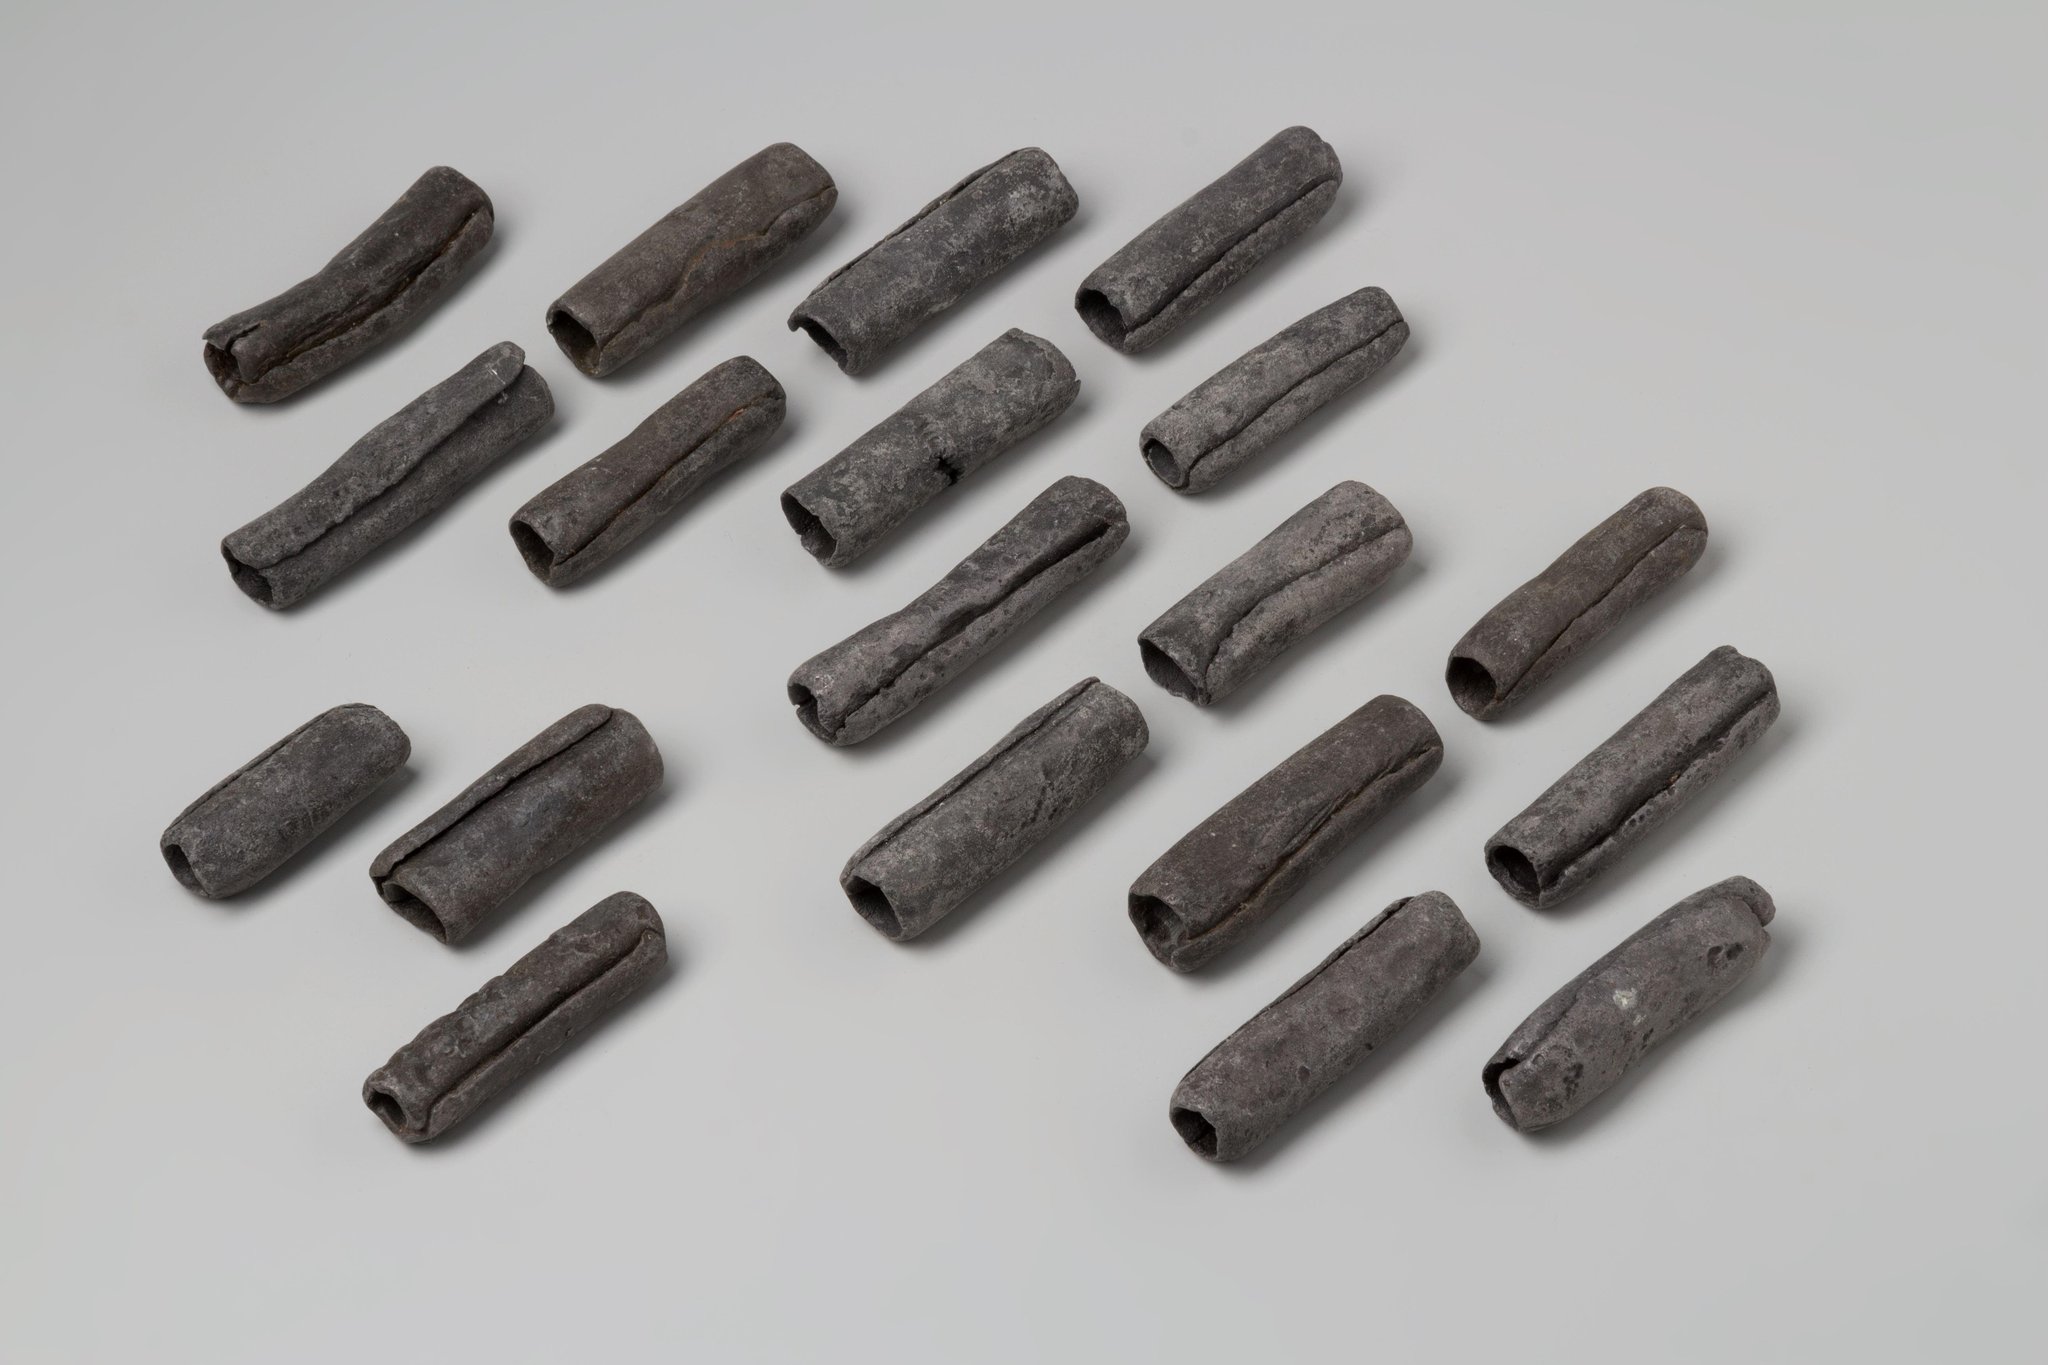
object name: lead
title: Rollen lood uit het wrak van de Oost-Indiëvaarder 't Vliegend Hart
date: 1700-1735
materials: lead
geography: netherlands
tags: 't vliegend hart (schip), verenigde oostindische compagnie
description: Negentien rollen lood waarvan éen met het merk A.M. Vermoedelijk zaten deze rollen aan visnetten ofwel aan boord van de Vliegend Hart of die zijn blijven steken aan het wrak. Loden rol, roll of lead.